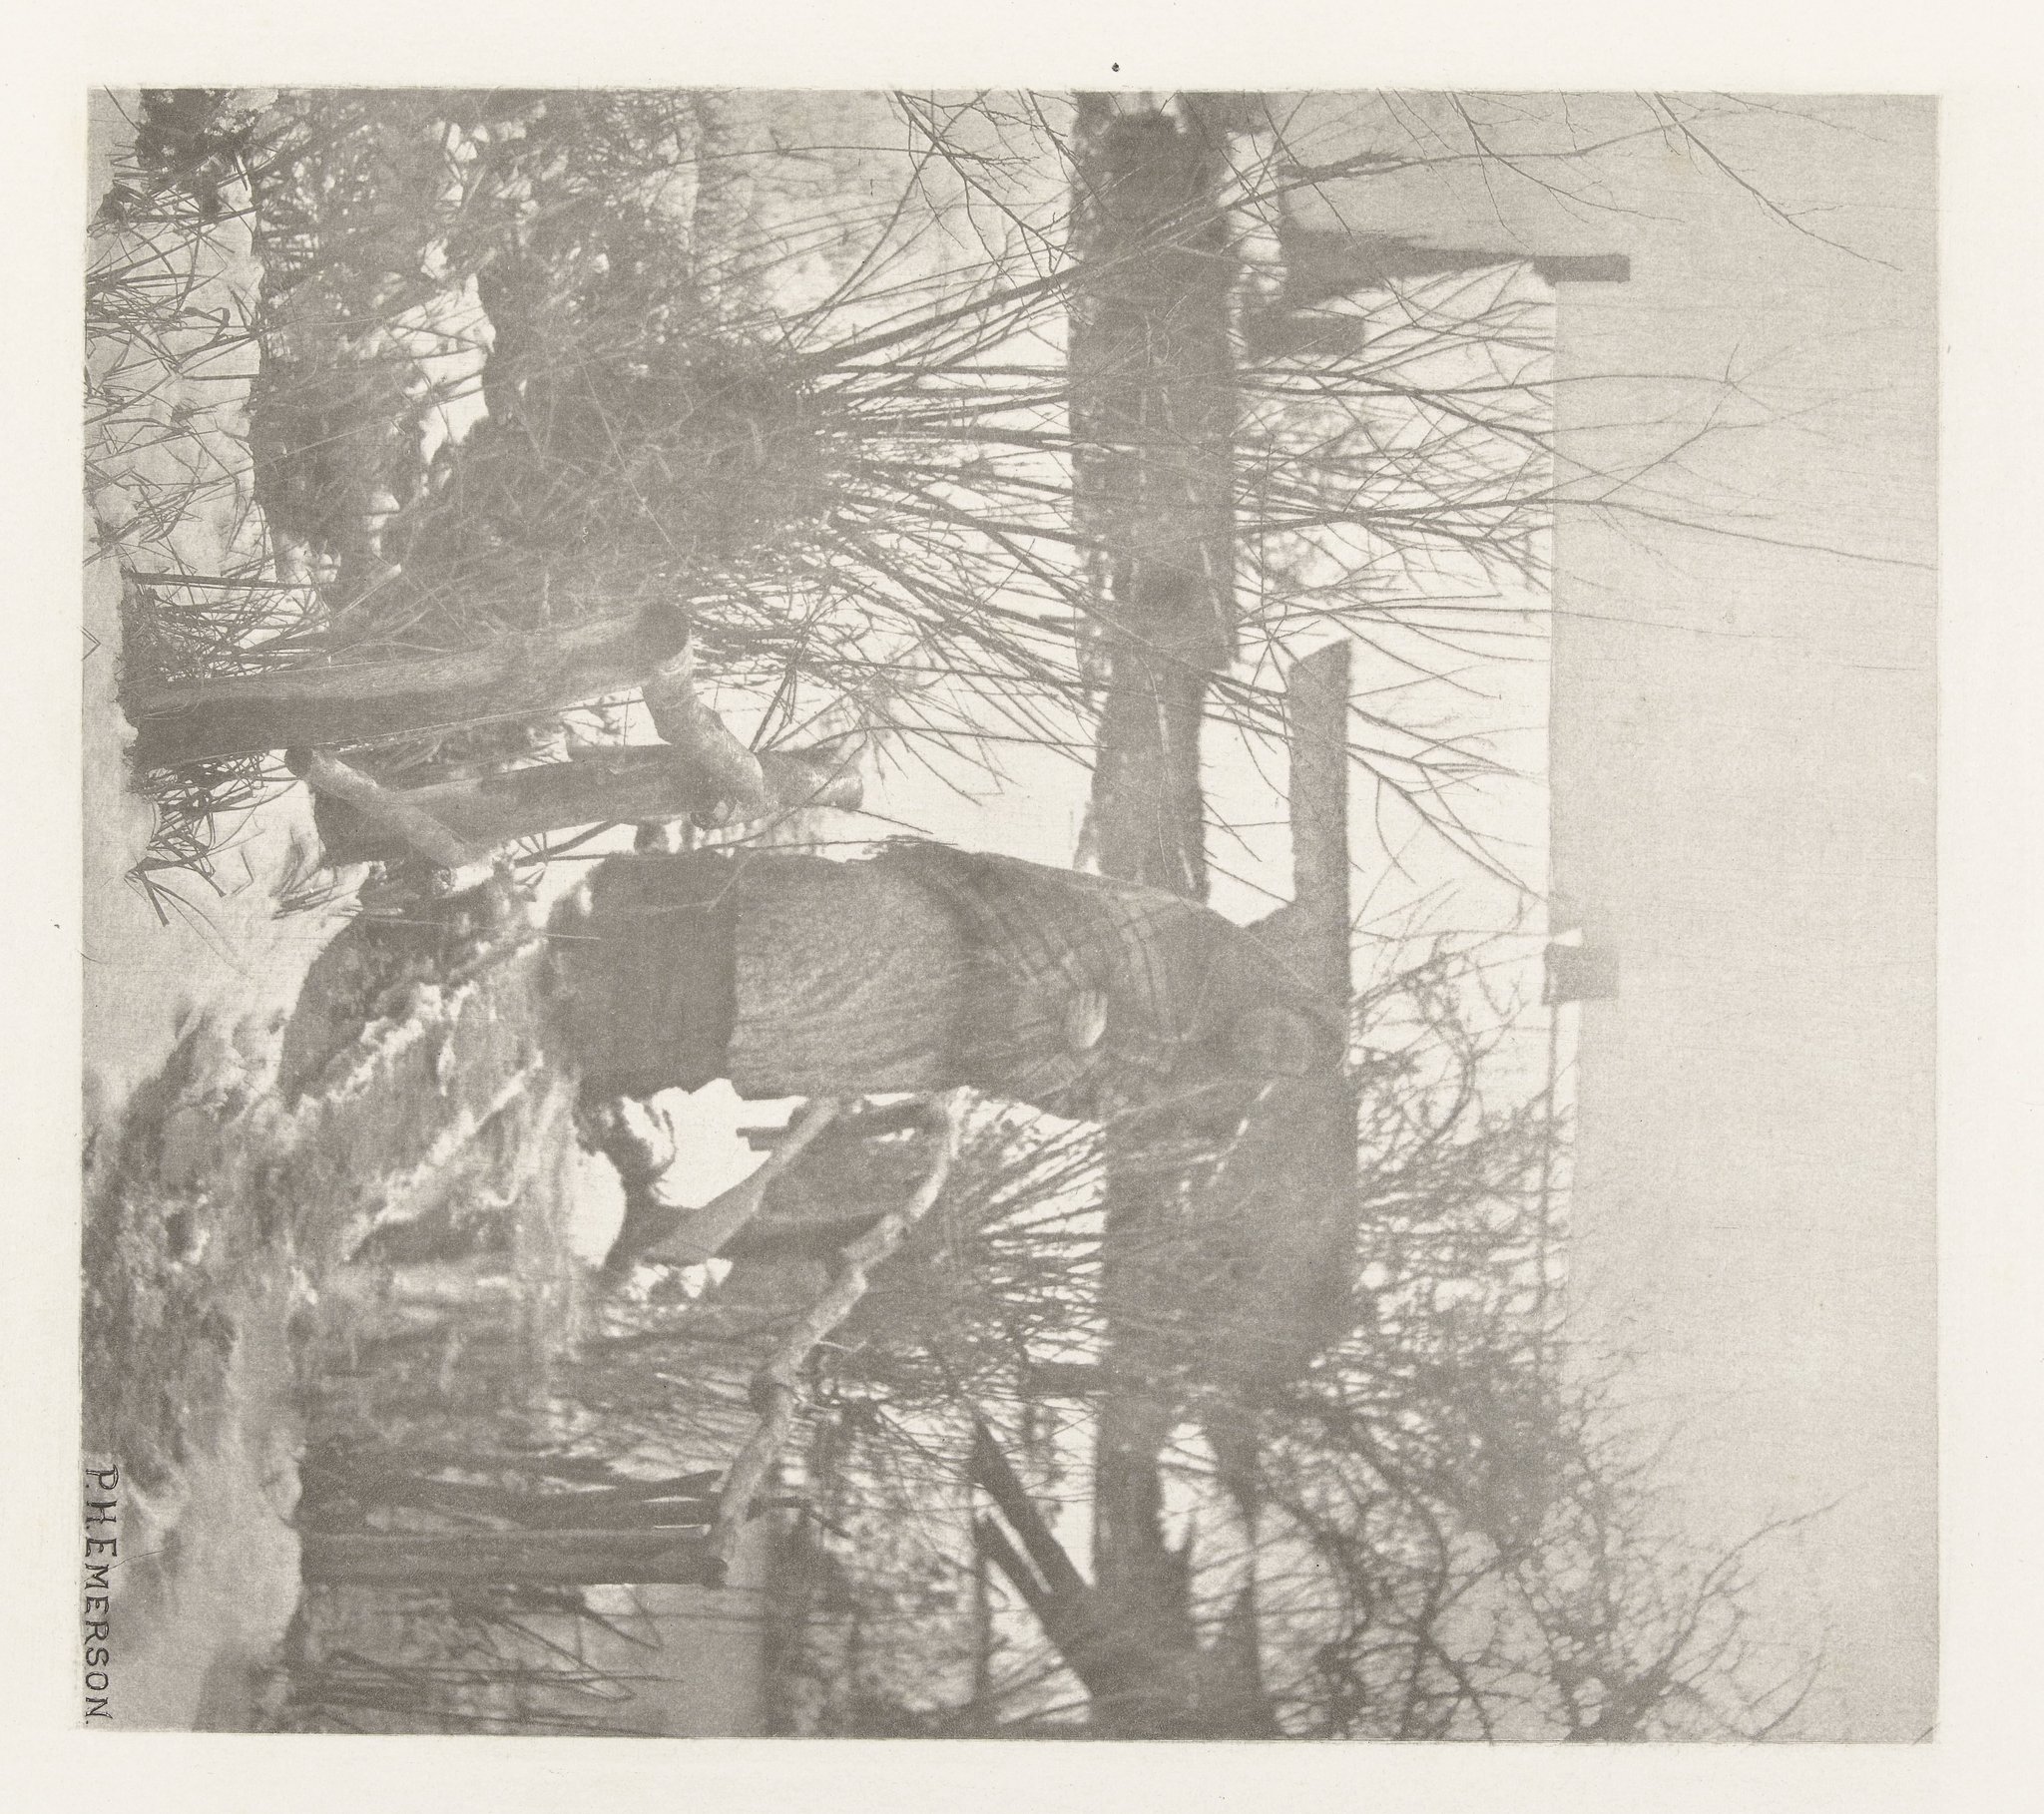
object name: photomechanical print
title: A Slippery Path - Winter Scene (Norfolk)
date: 1883-1888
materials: paper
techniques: photoaquatint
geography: norfolk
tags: adult woman, landscape with bridge, viaduct or aqueduct, snow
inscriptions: inscription: ‘Plate XXIII.’